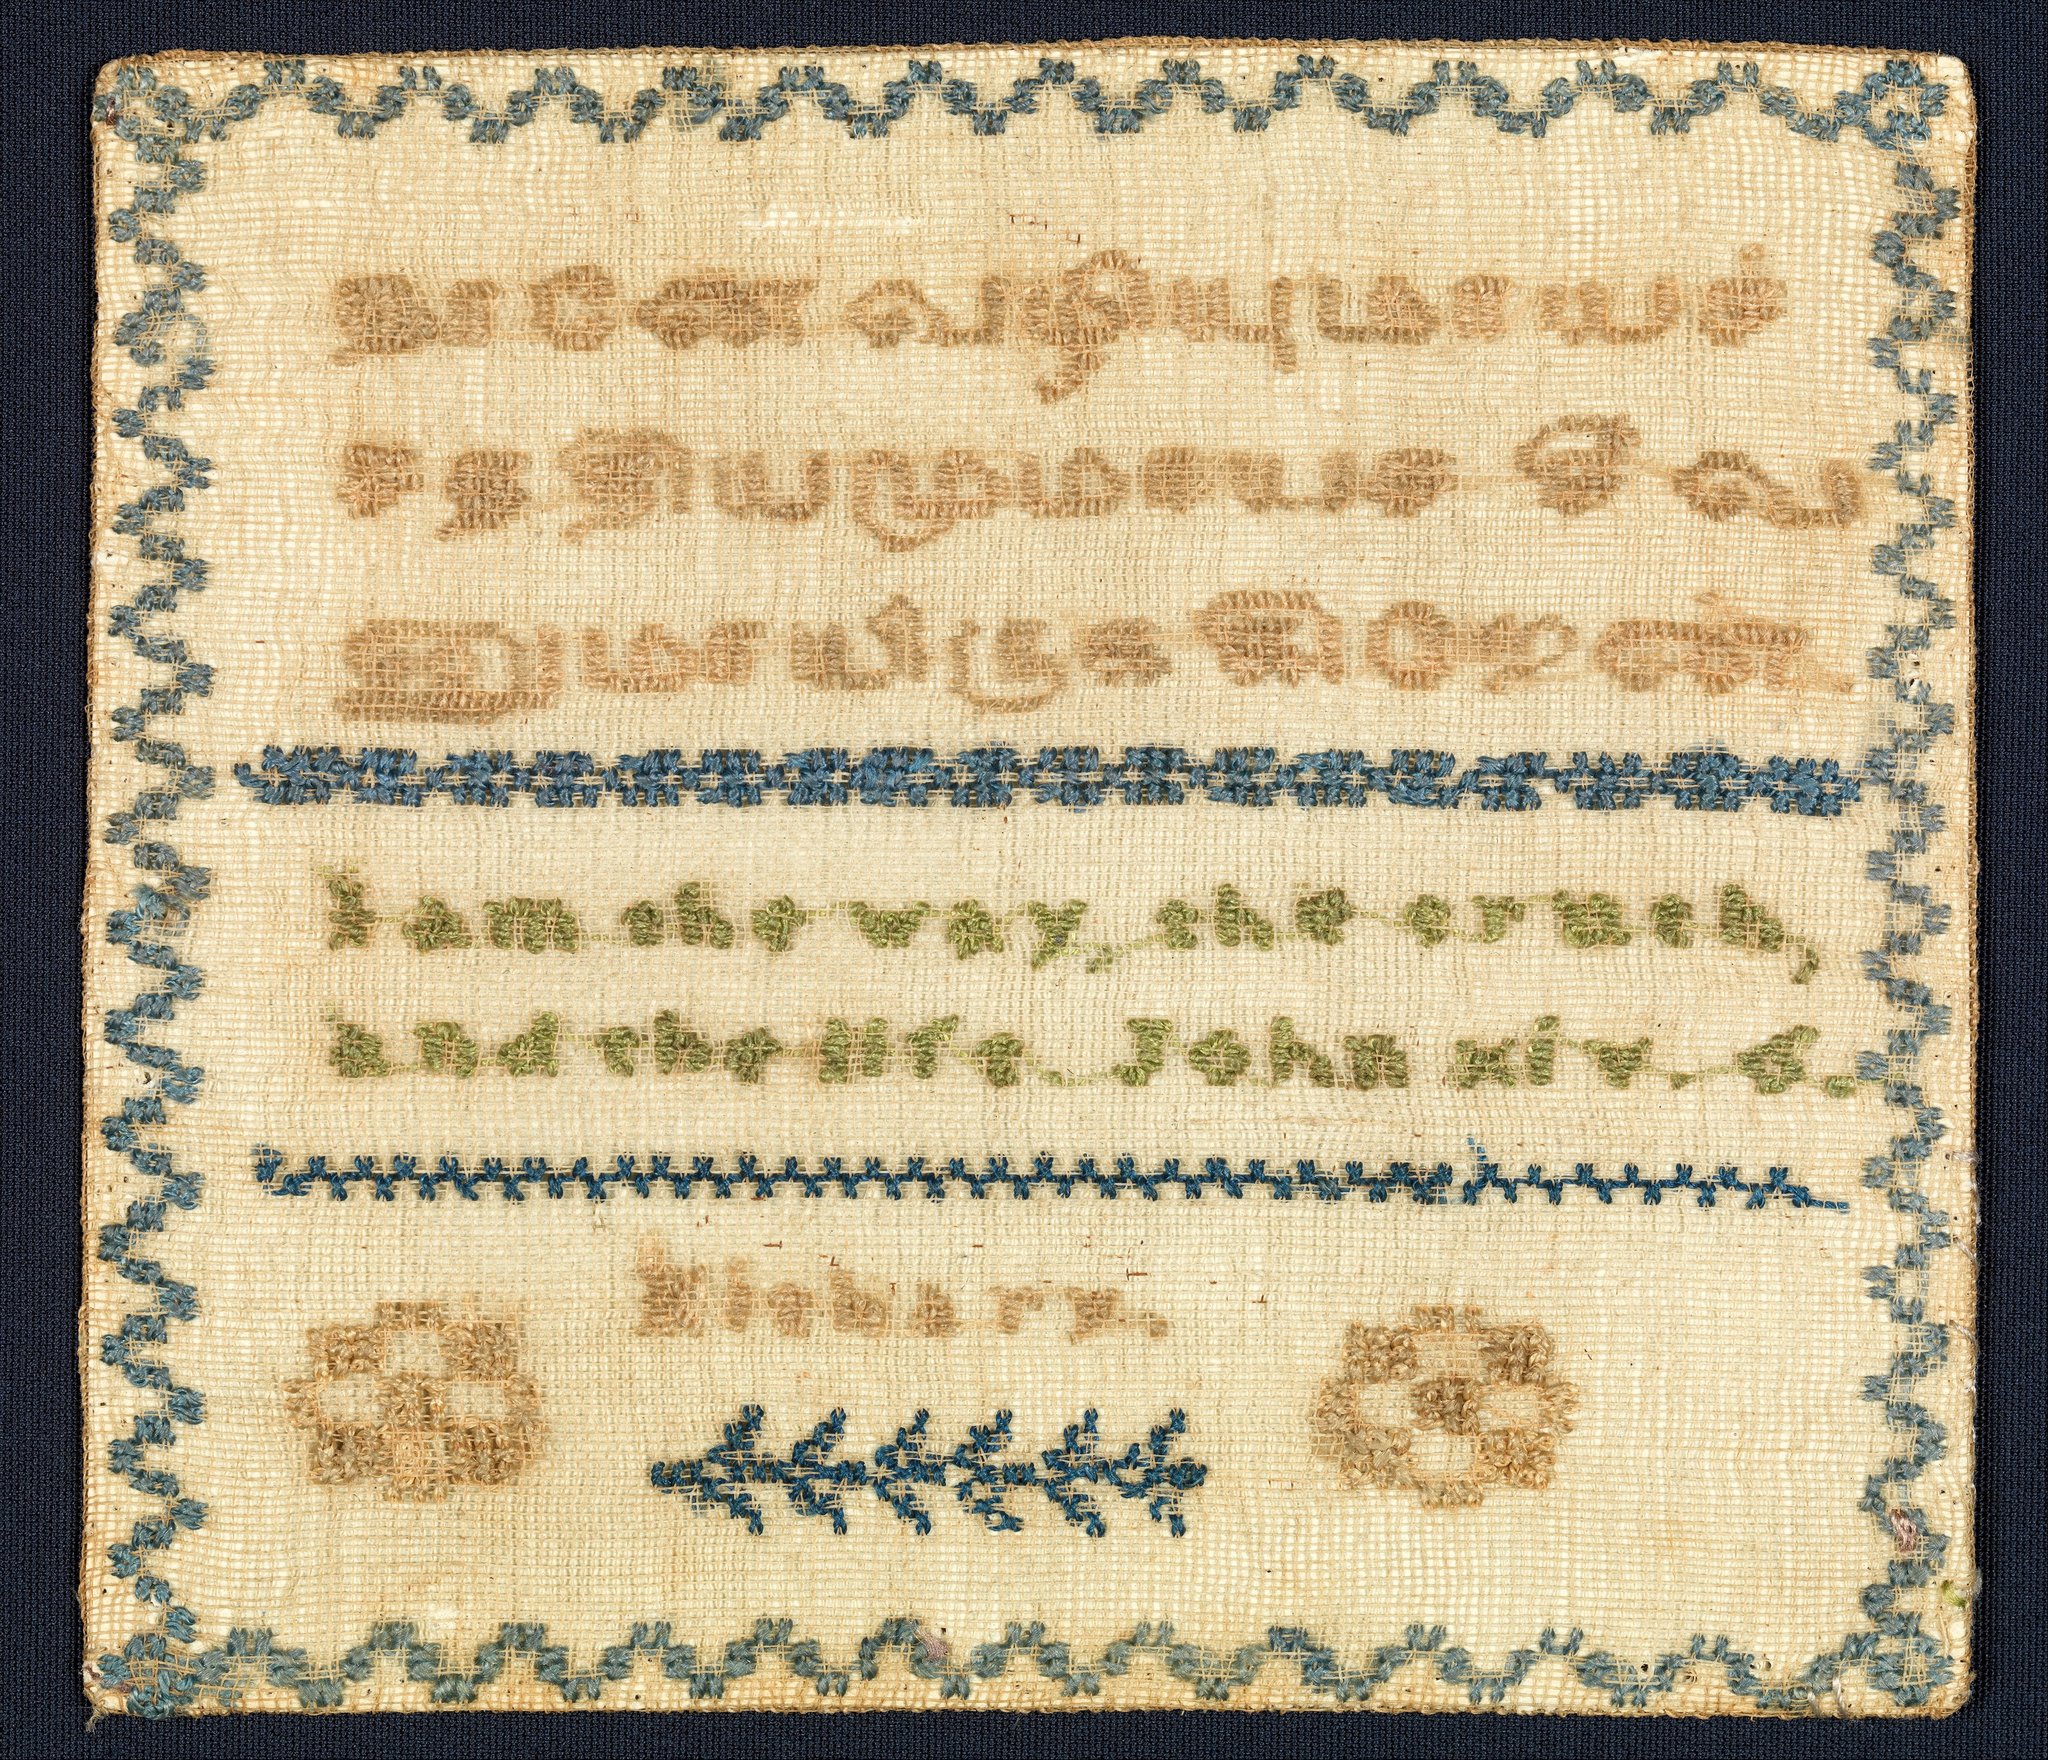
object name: sampler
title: Sampler with biblical verse in Tamil and English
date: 1801-1900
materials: canvas, silk